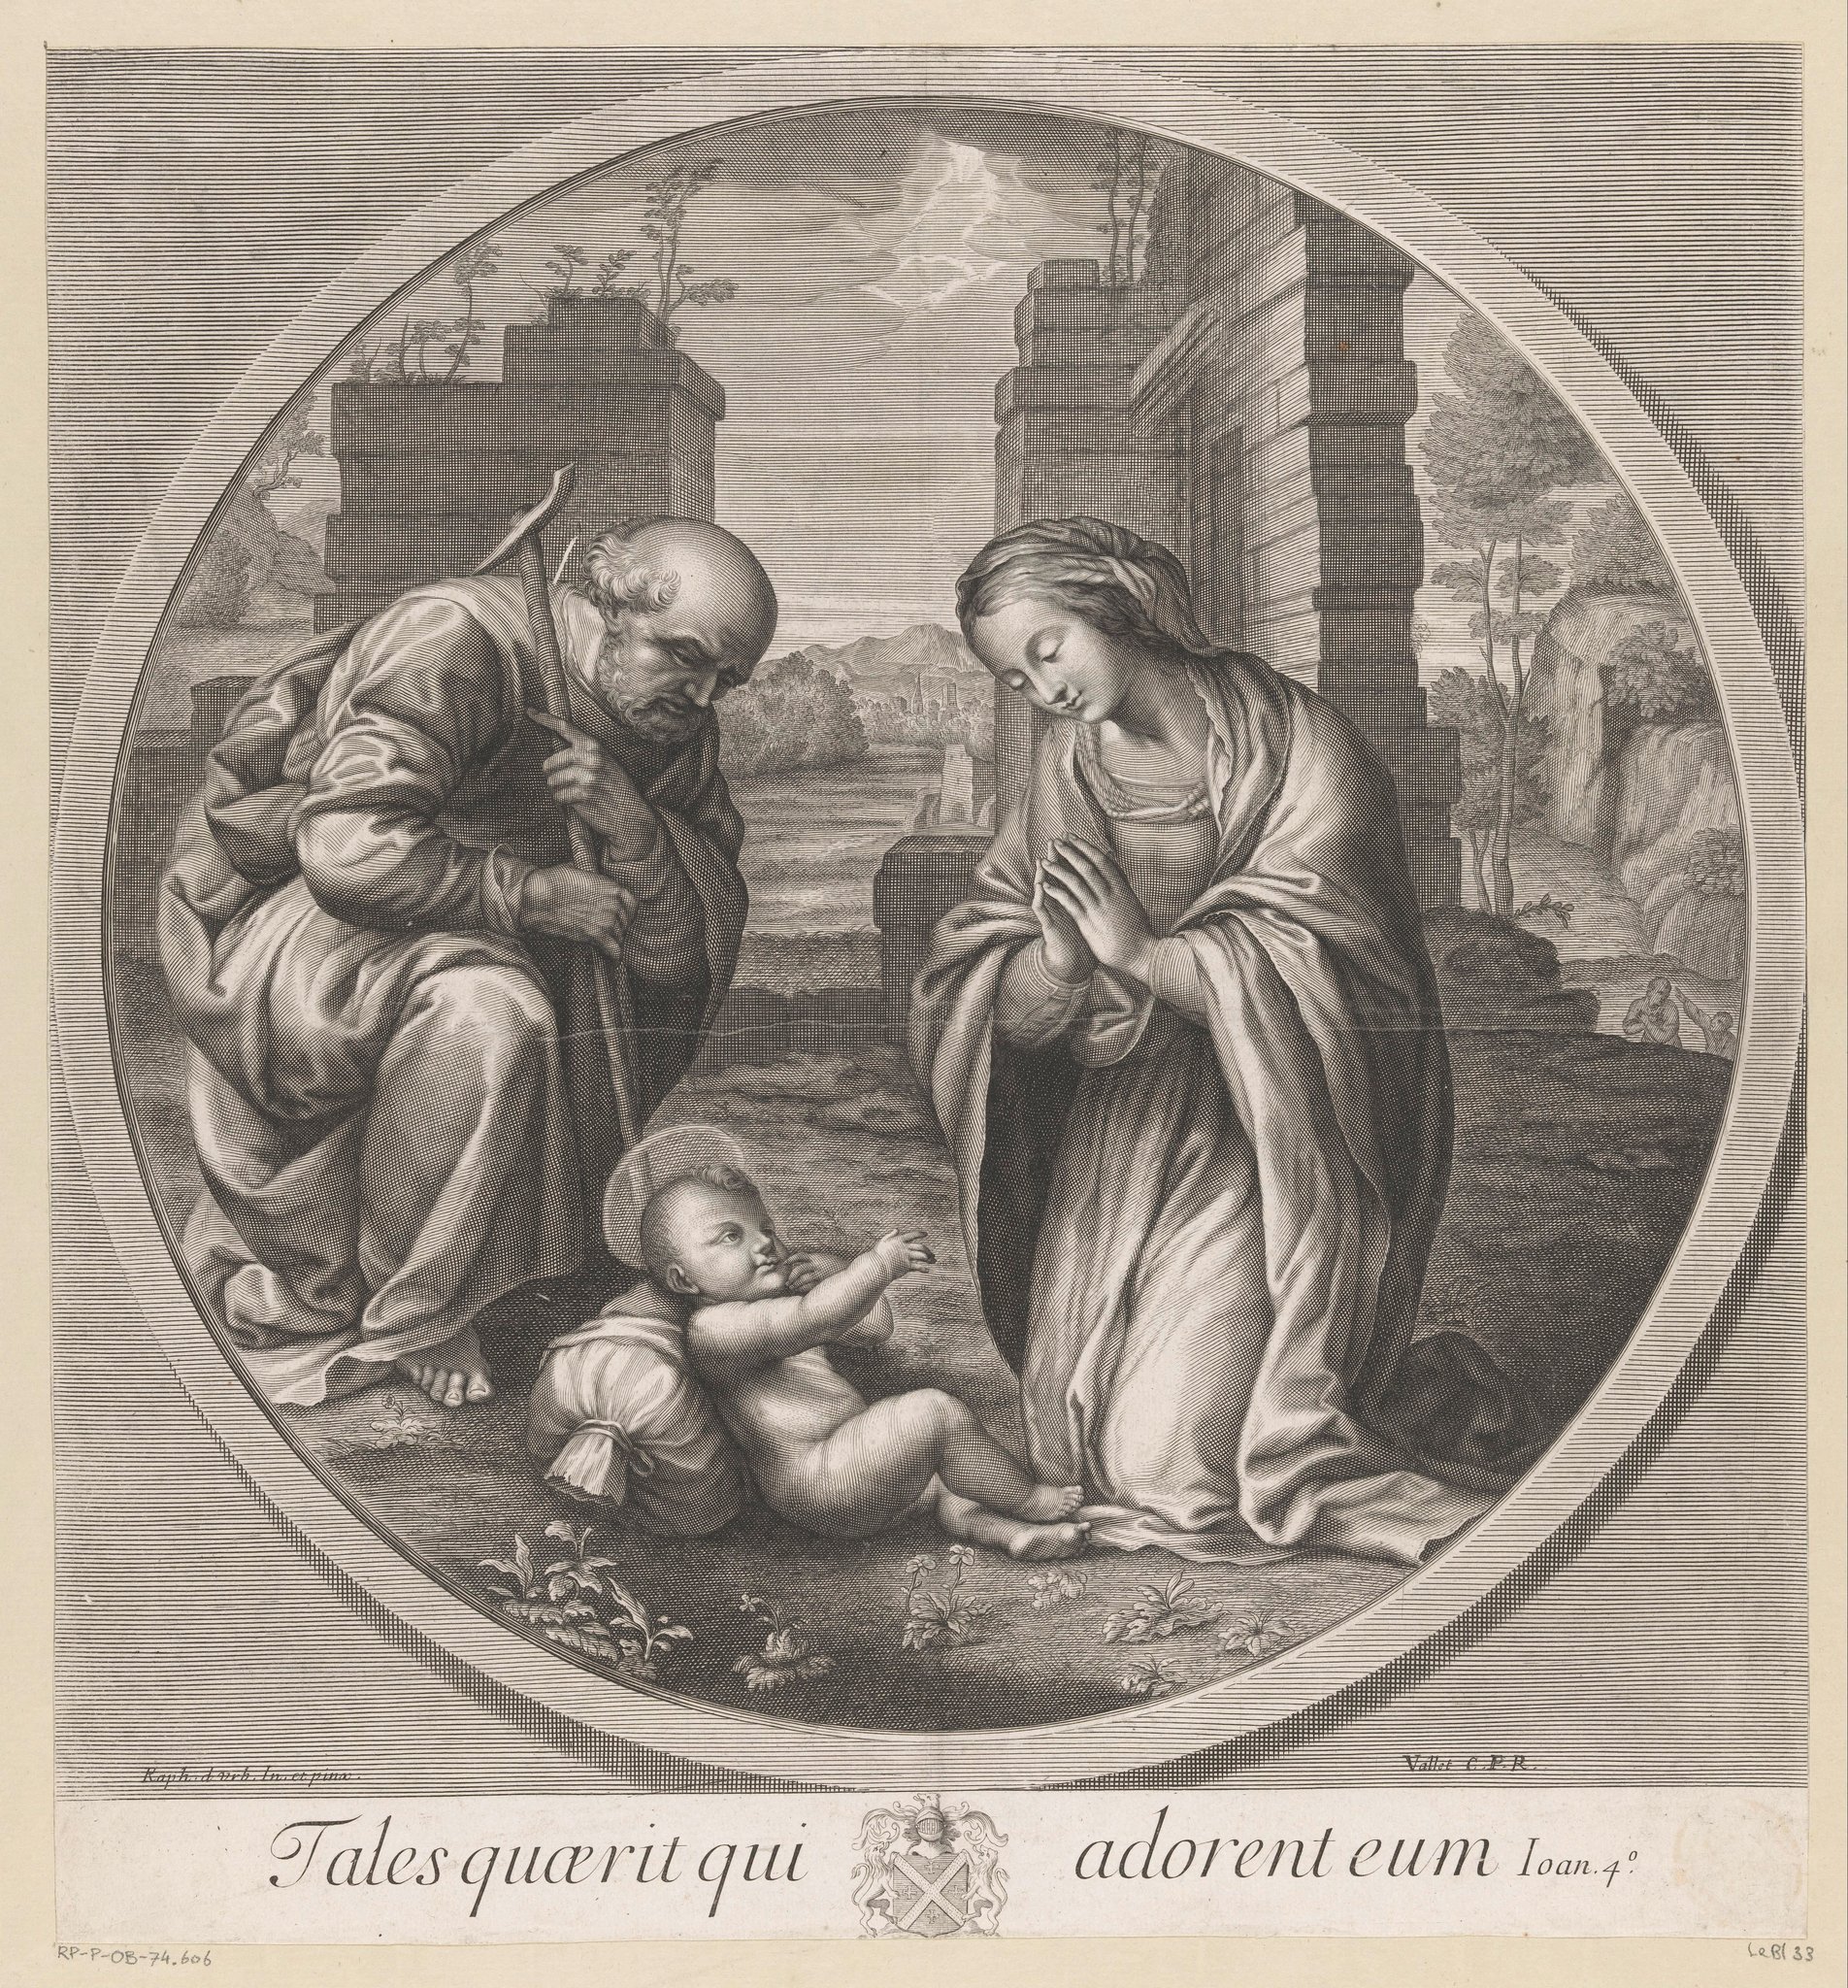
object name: print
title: Aanbidding door Jozef en Maria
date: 1661-1704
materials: paper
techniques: engraving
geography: paris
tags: adoration of the christ-child by mary and joseph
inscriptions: collector's mark: Lugt 240